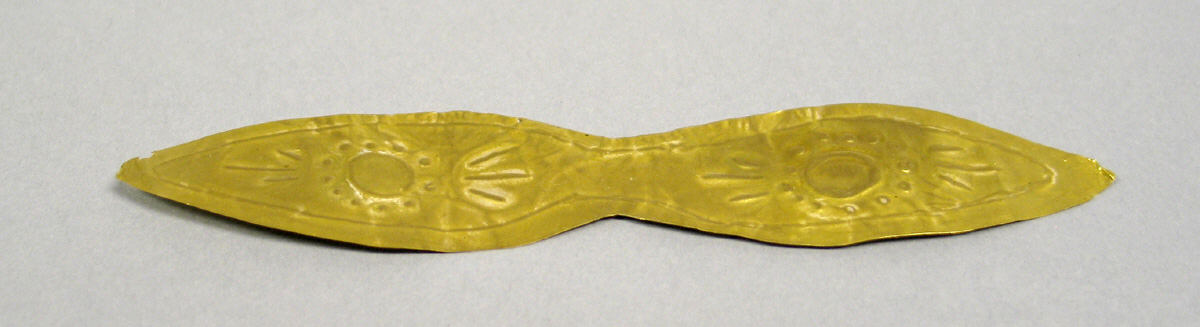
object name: mask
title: Ritual Eye Mask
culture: indonesian, javanese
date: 201-300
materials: gold